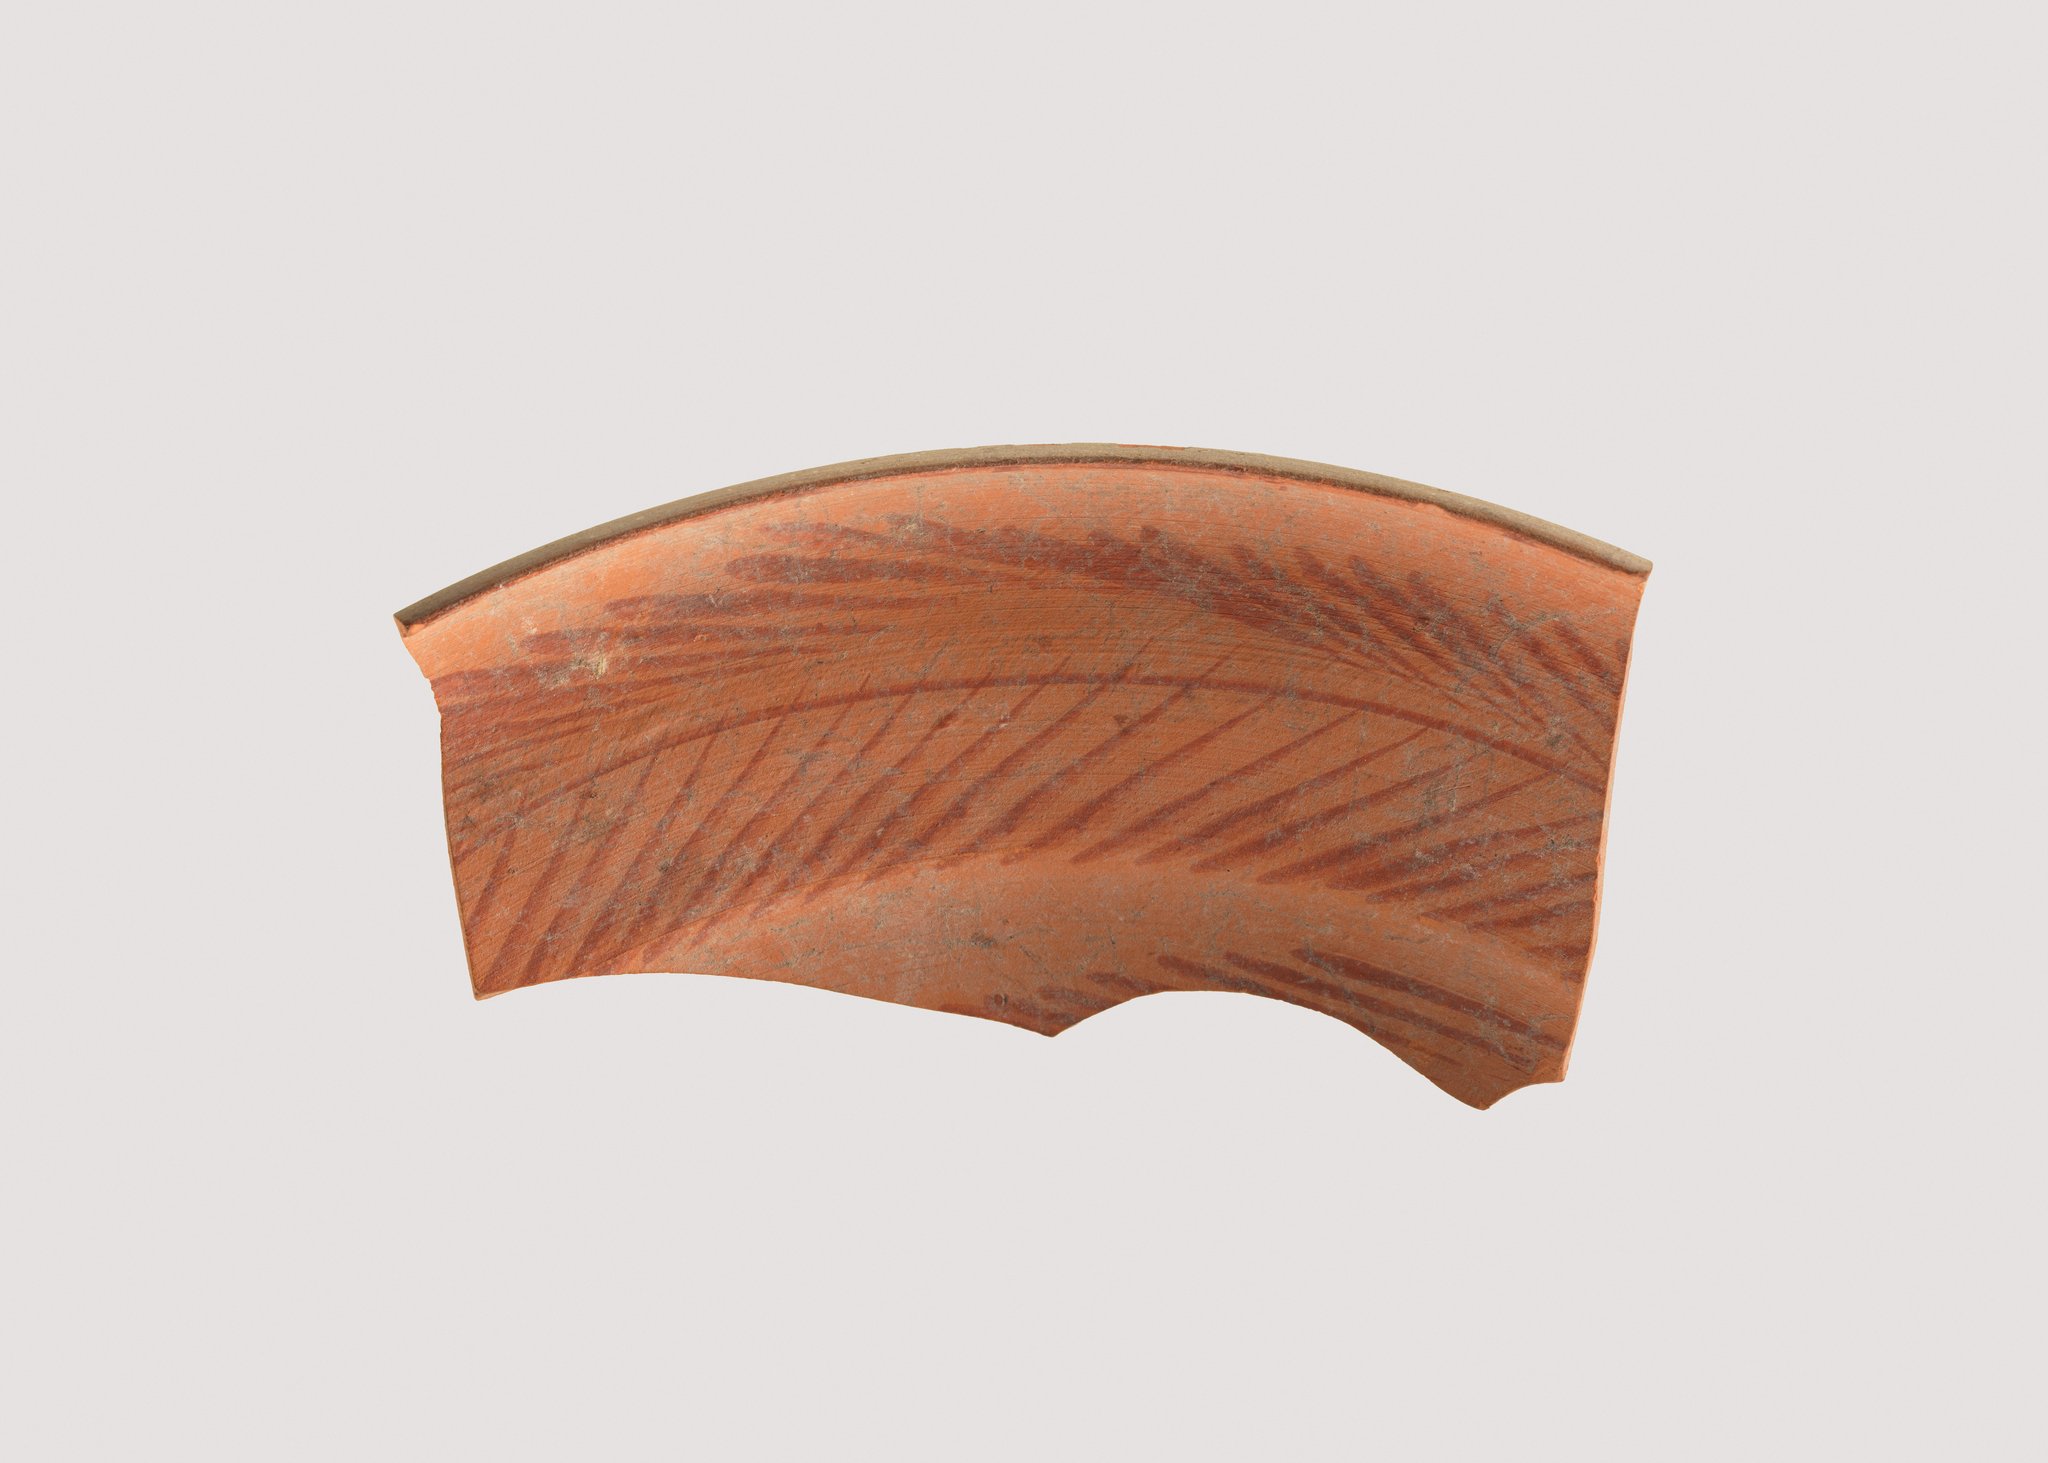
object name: sherd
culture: nabataean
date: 1-100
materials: ceramic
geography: levant